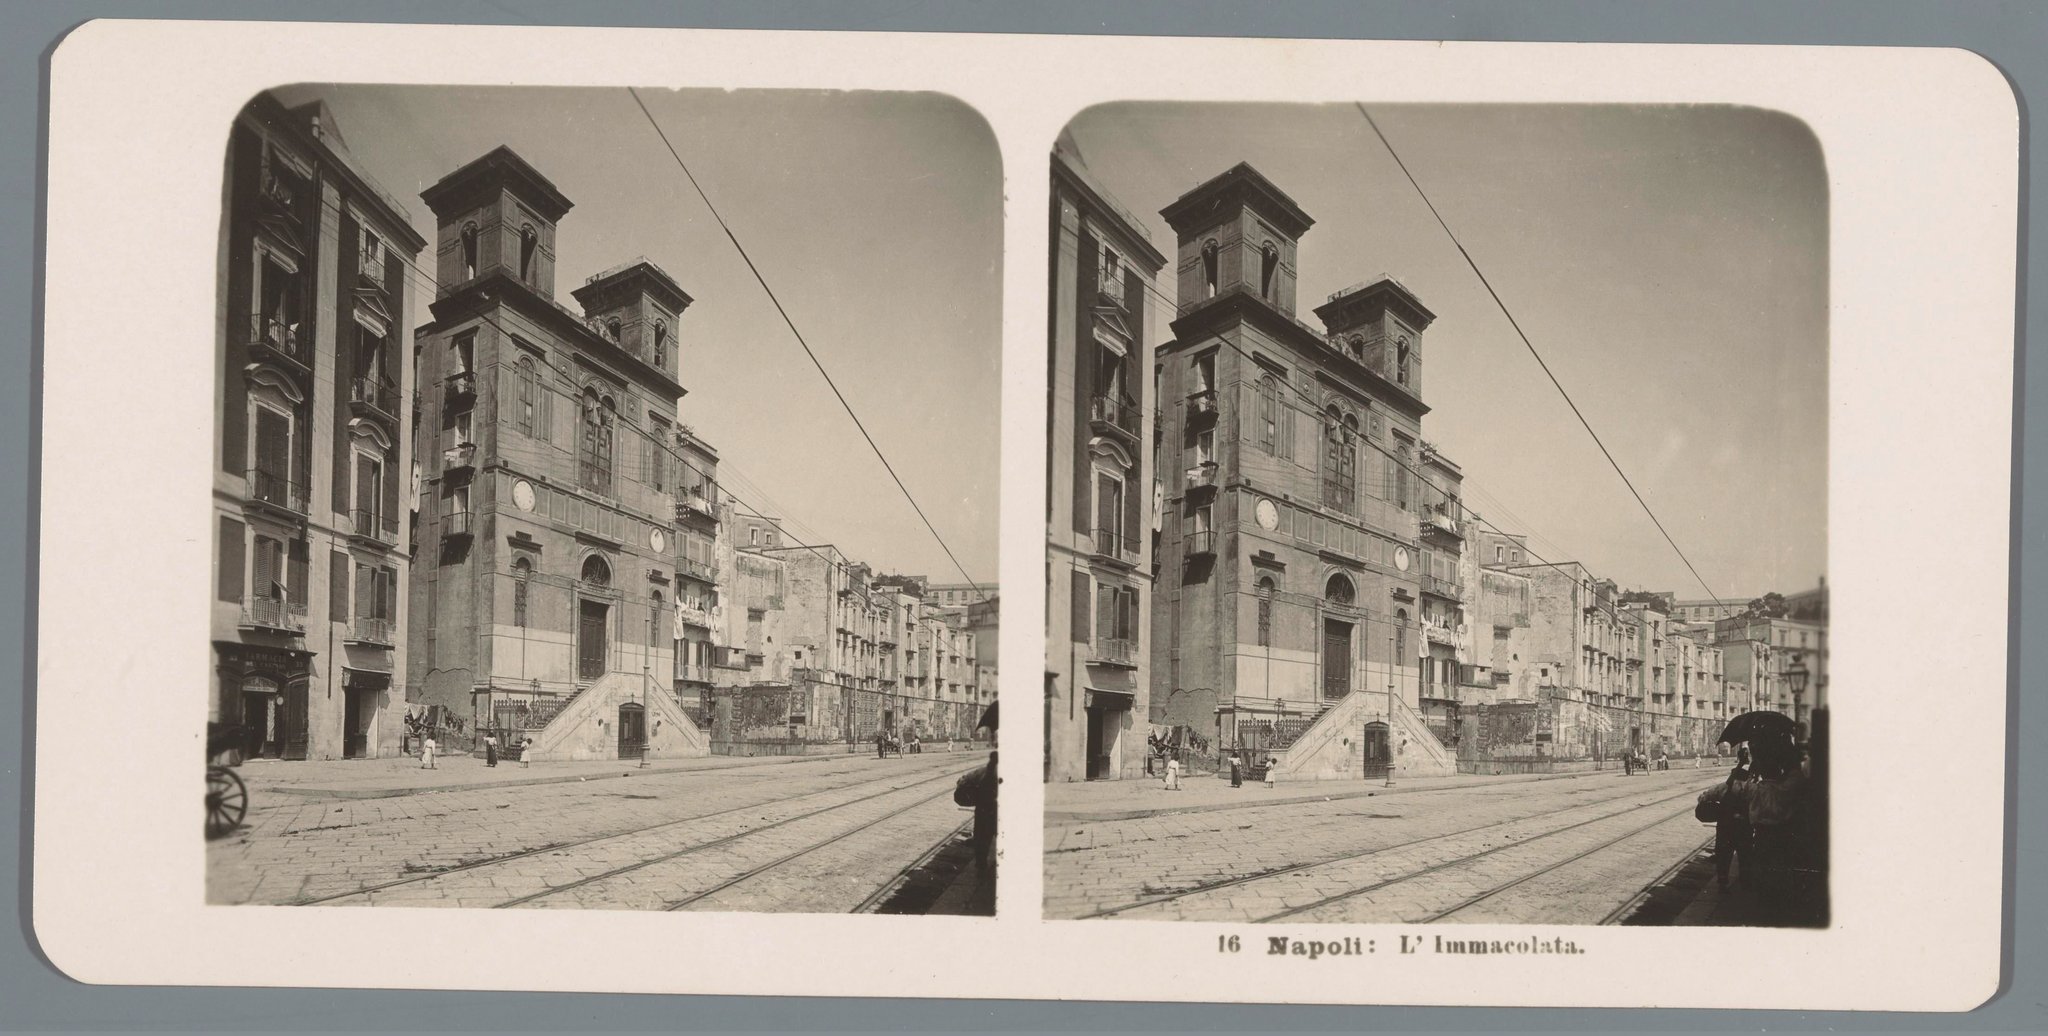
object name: stereograph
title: Napoli: L'immacolata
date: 1906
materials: cardboard, photographic support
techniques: gelatin silver print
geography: naples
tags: church (exterior), façade (of house or building), street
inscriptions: number: ‘16’, inscription: ‘Neue Photographische Gesellschaft A. G. Steglitz-Berlin 1906.’